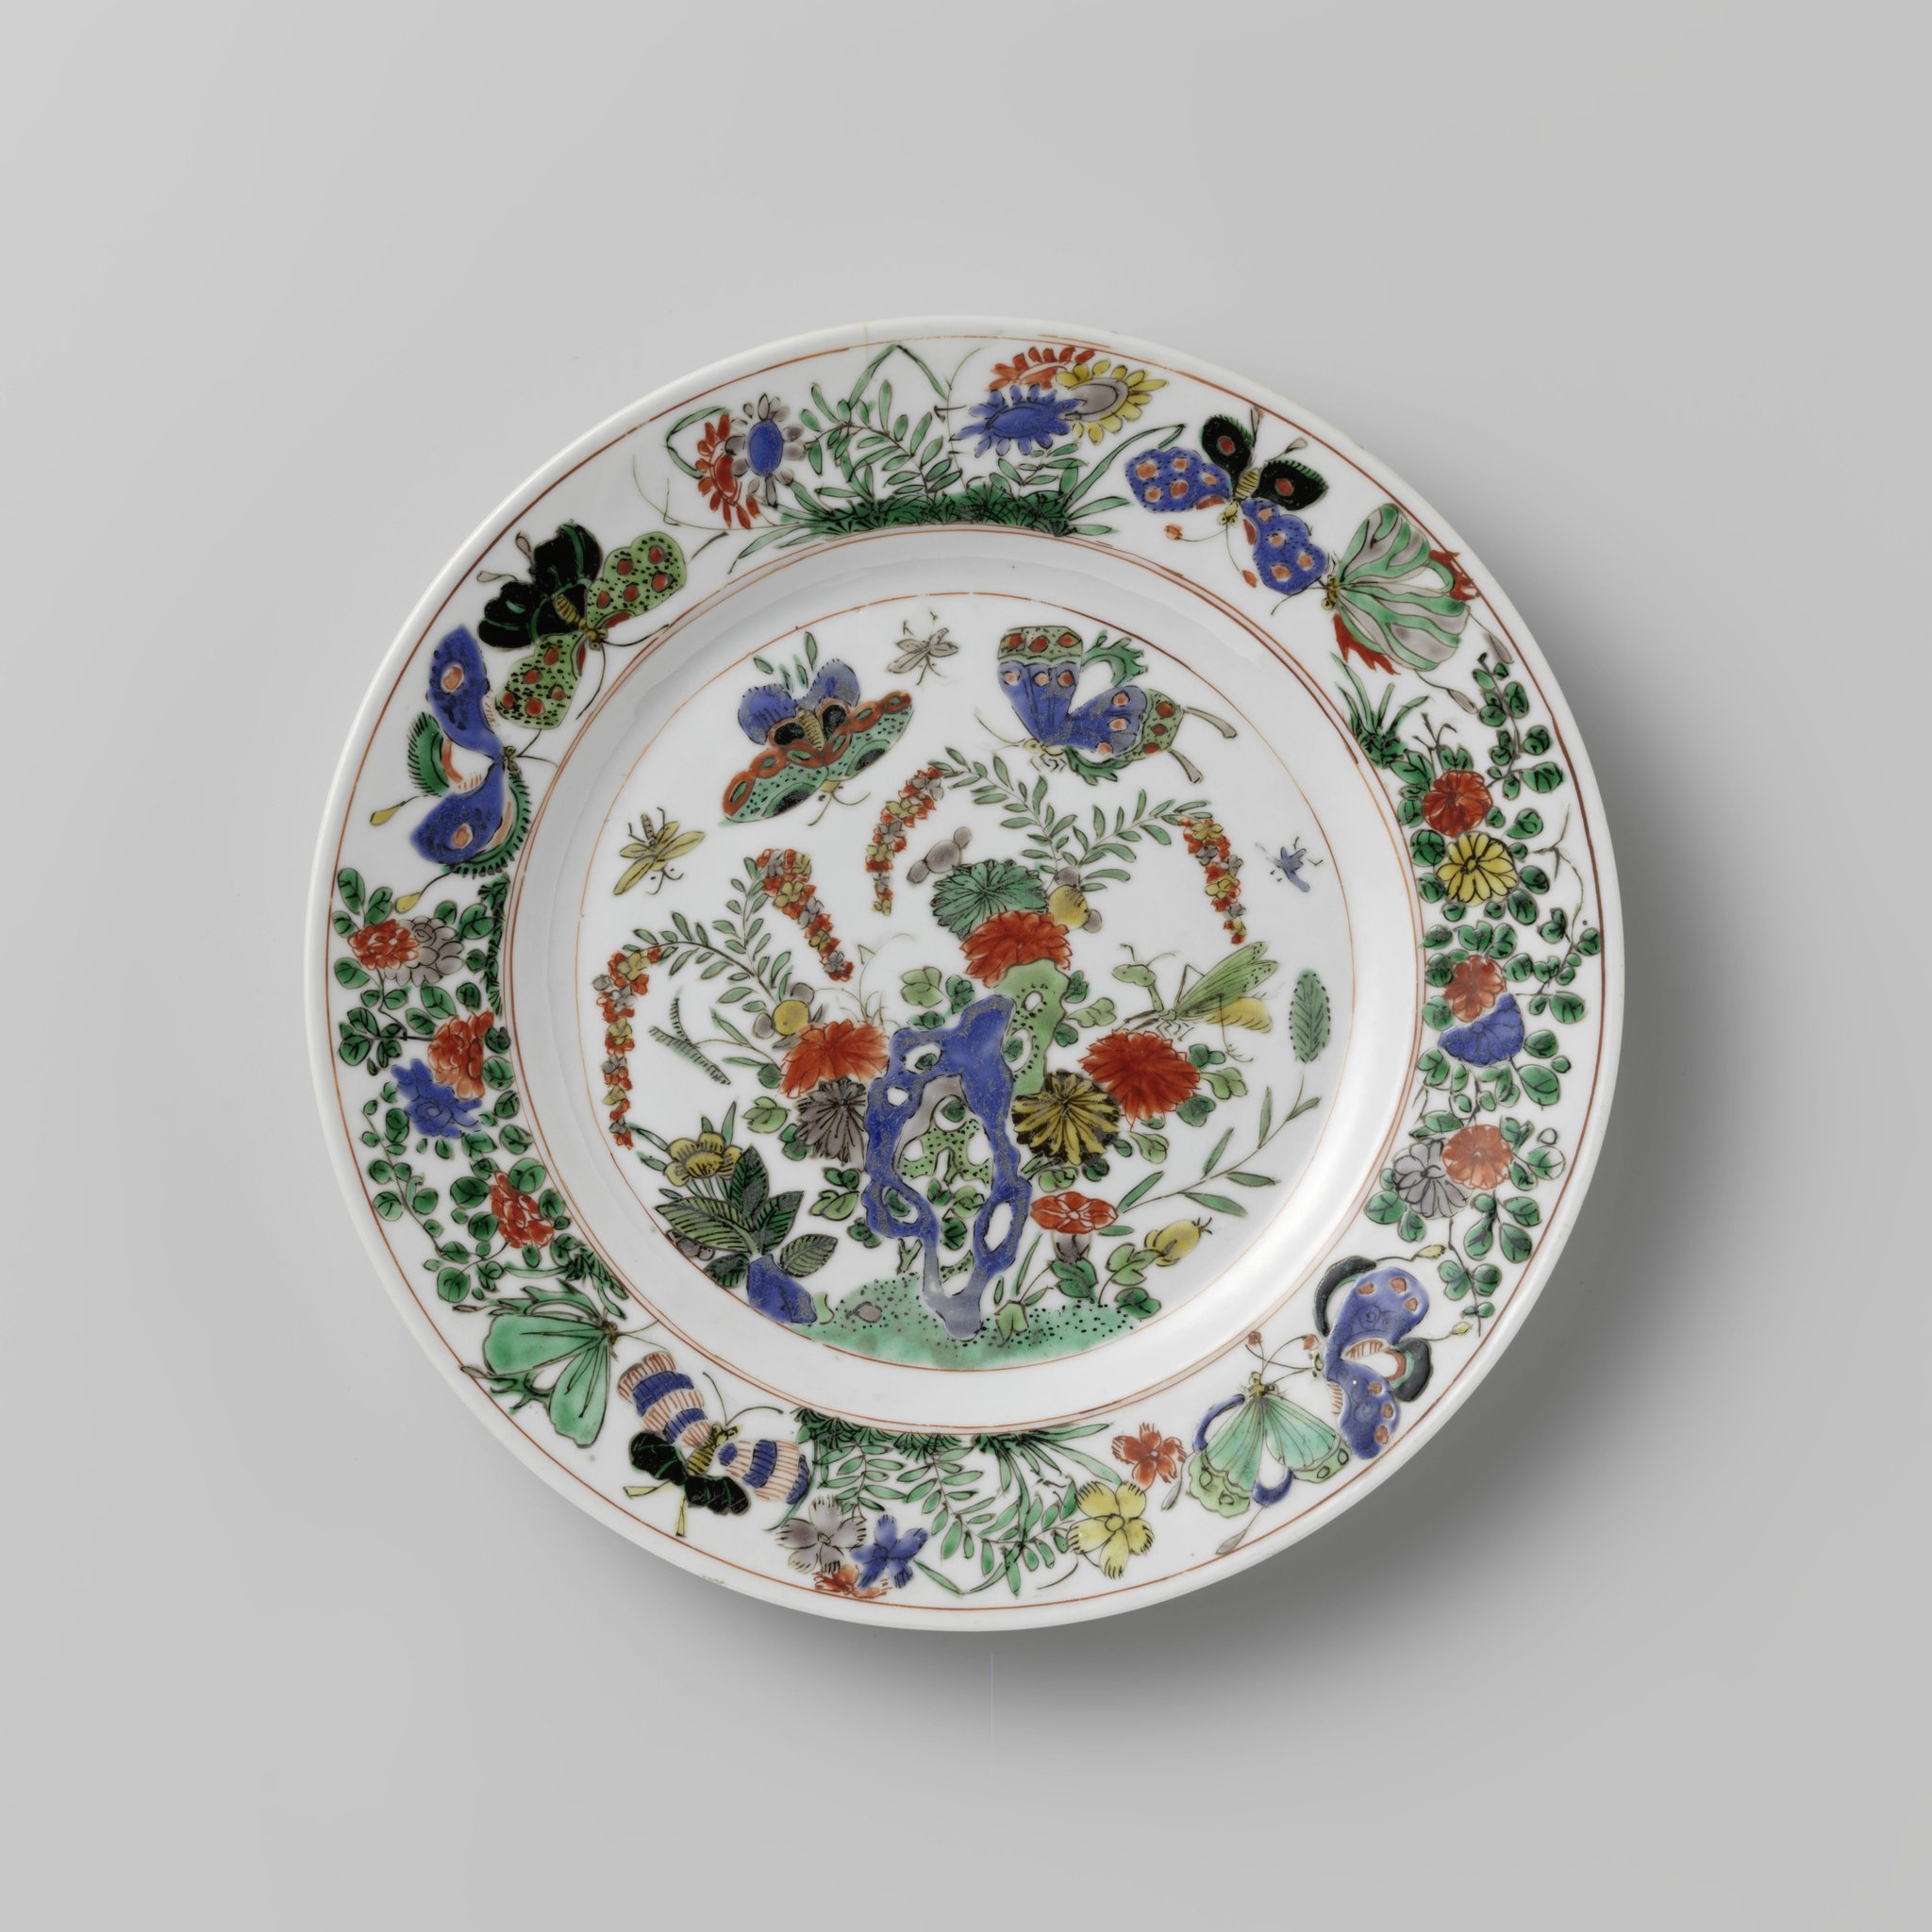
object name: plate dish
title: Plate with rock, butterflies and flowering plants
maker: Anonymous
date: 1700-1724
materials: cobalt, glaze, paint, porcelain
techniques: firing, turning, vitrification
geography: china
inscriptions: mark